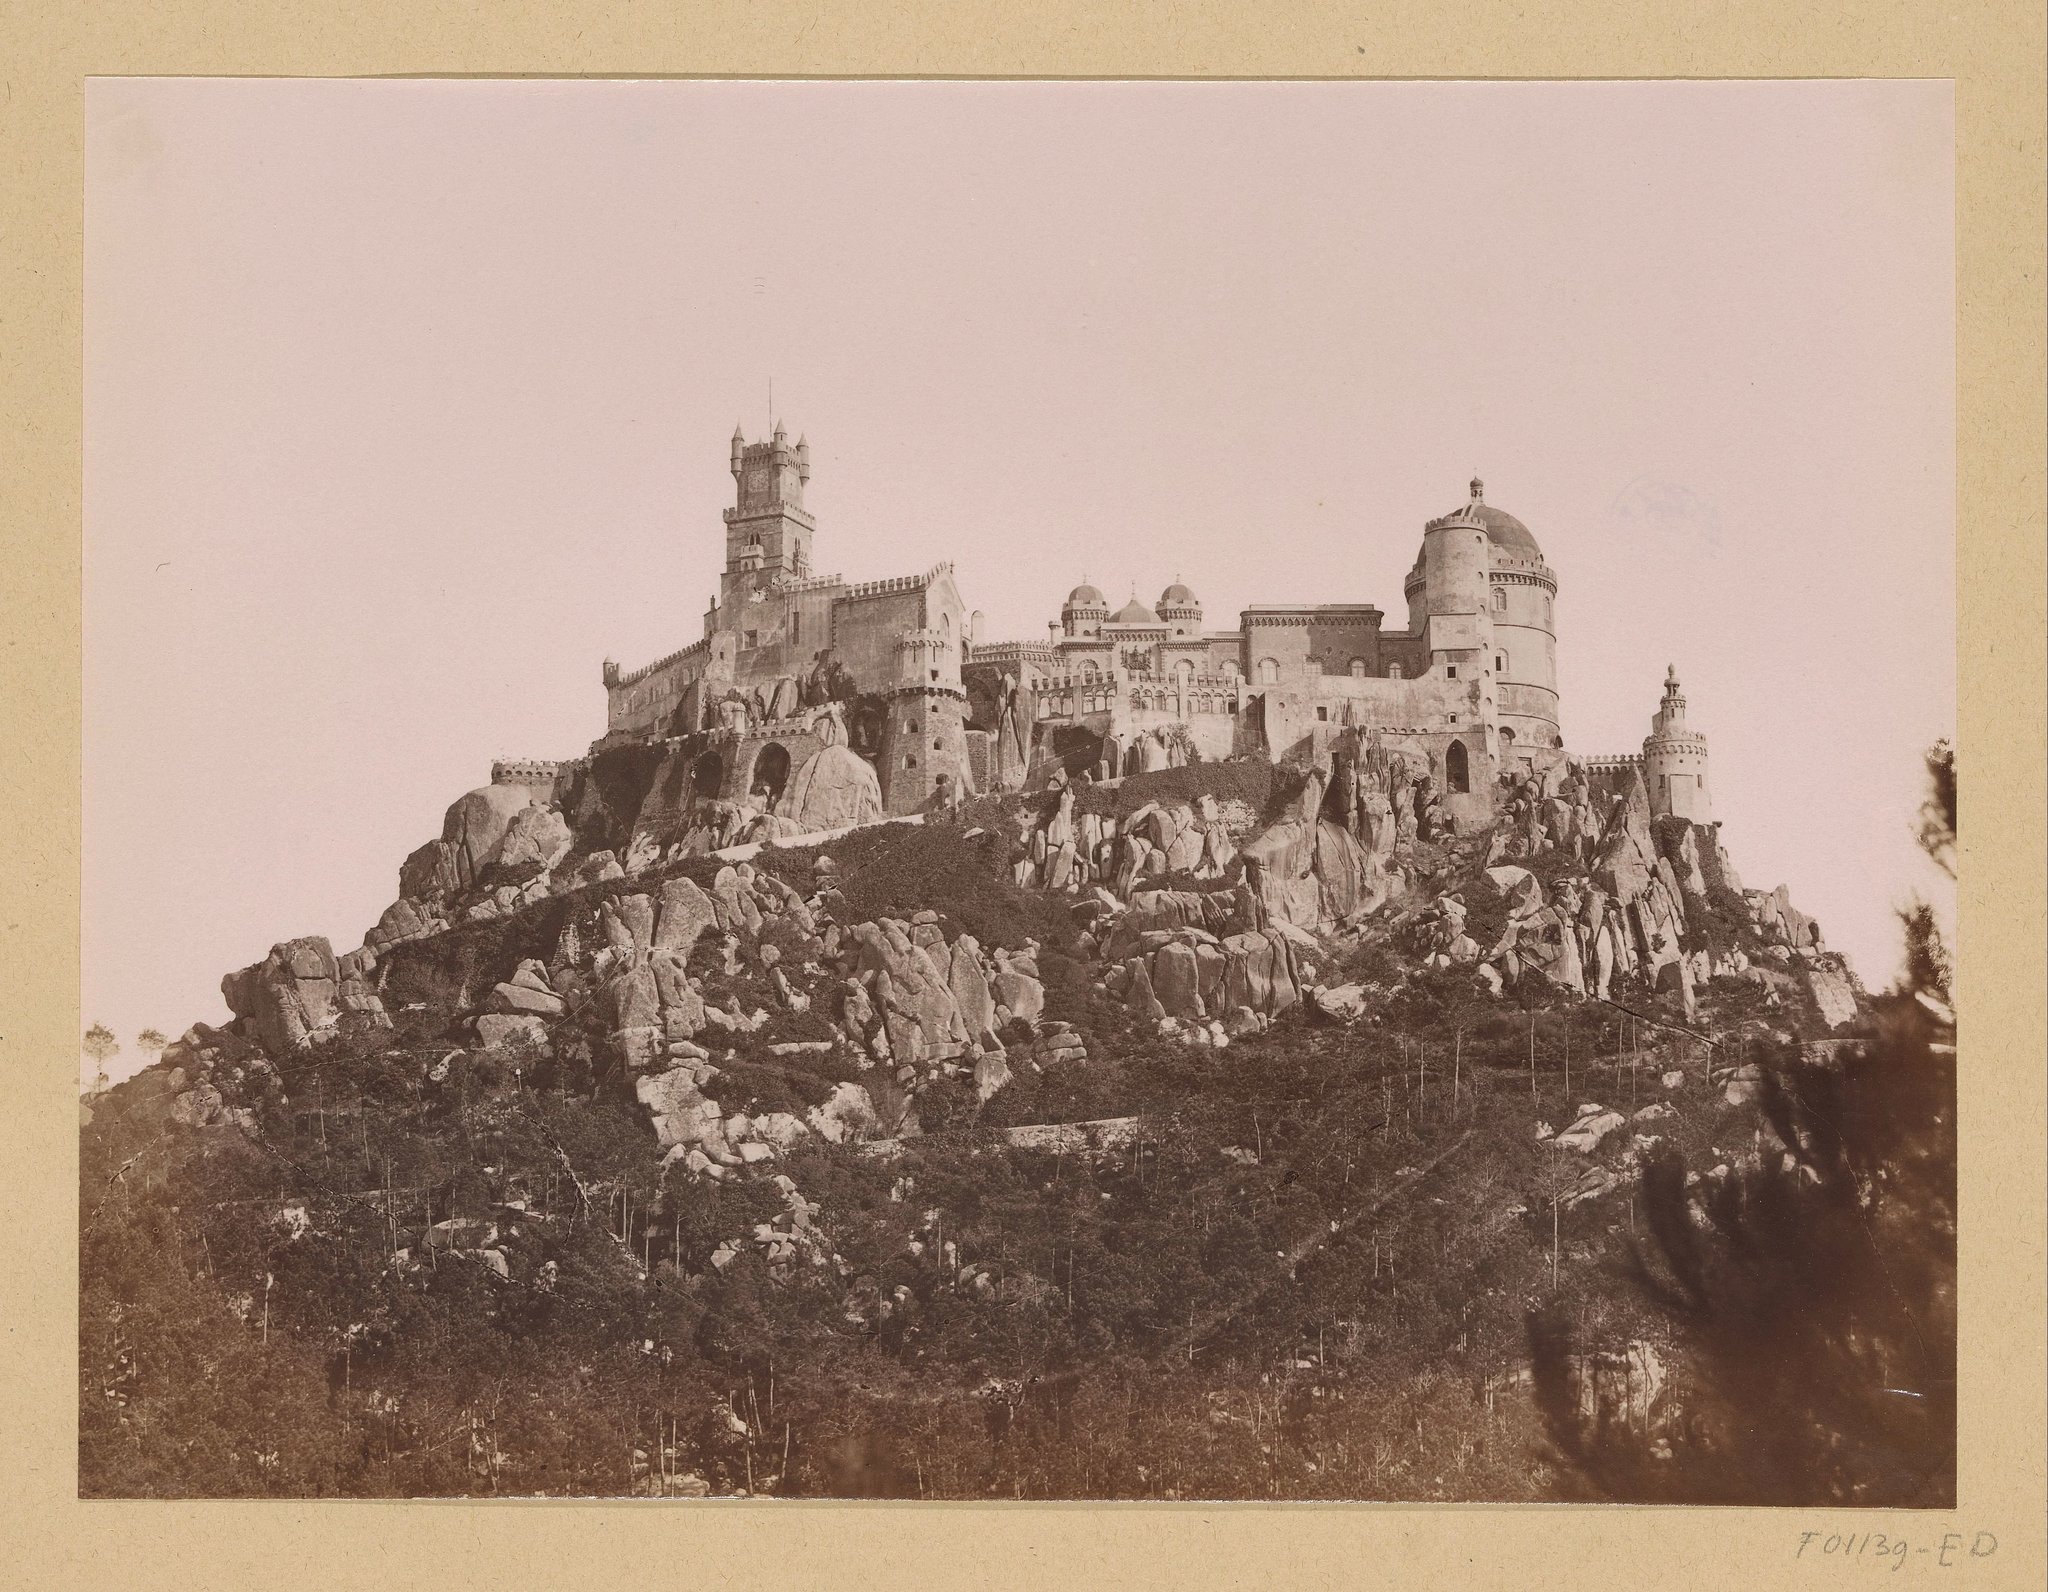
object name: album leaf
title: Gezicht op Palácio da Pena nabij Sintra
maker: Anonymous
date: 1851-1890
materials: paper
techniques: albumen print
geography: sintra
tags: castle